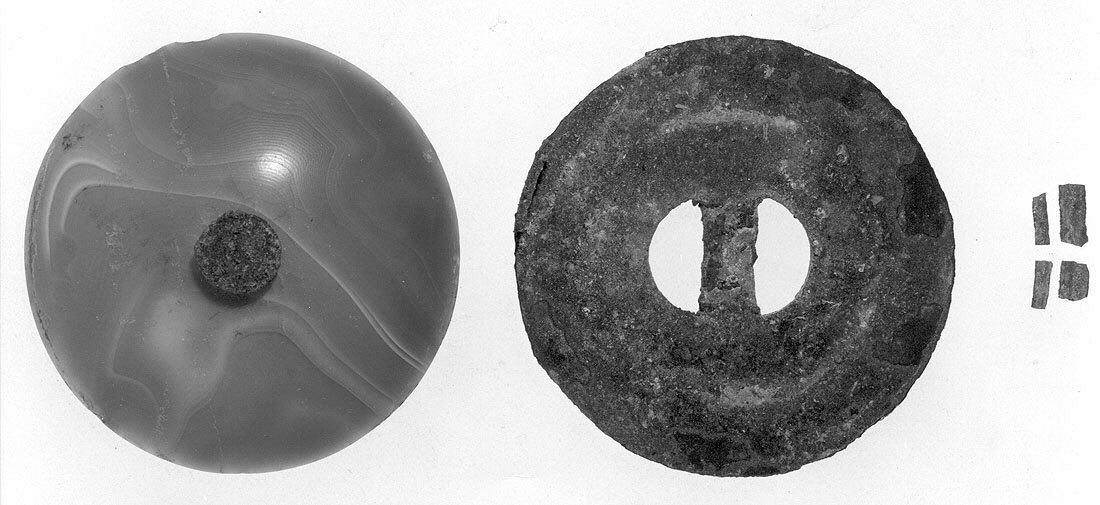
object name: roundel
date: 1000-668 BCE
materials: stone, bronze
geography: transcaucasia